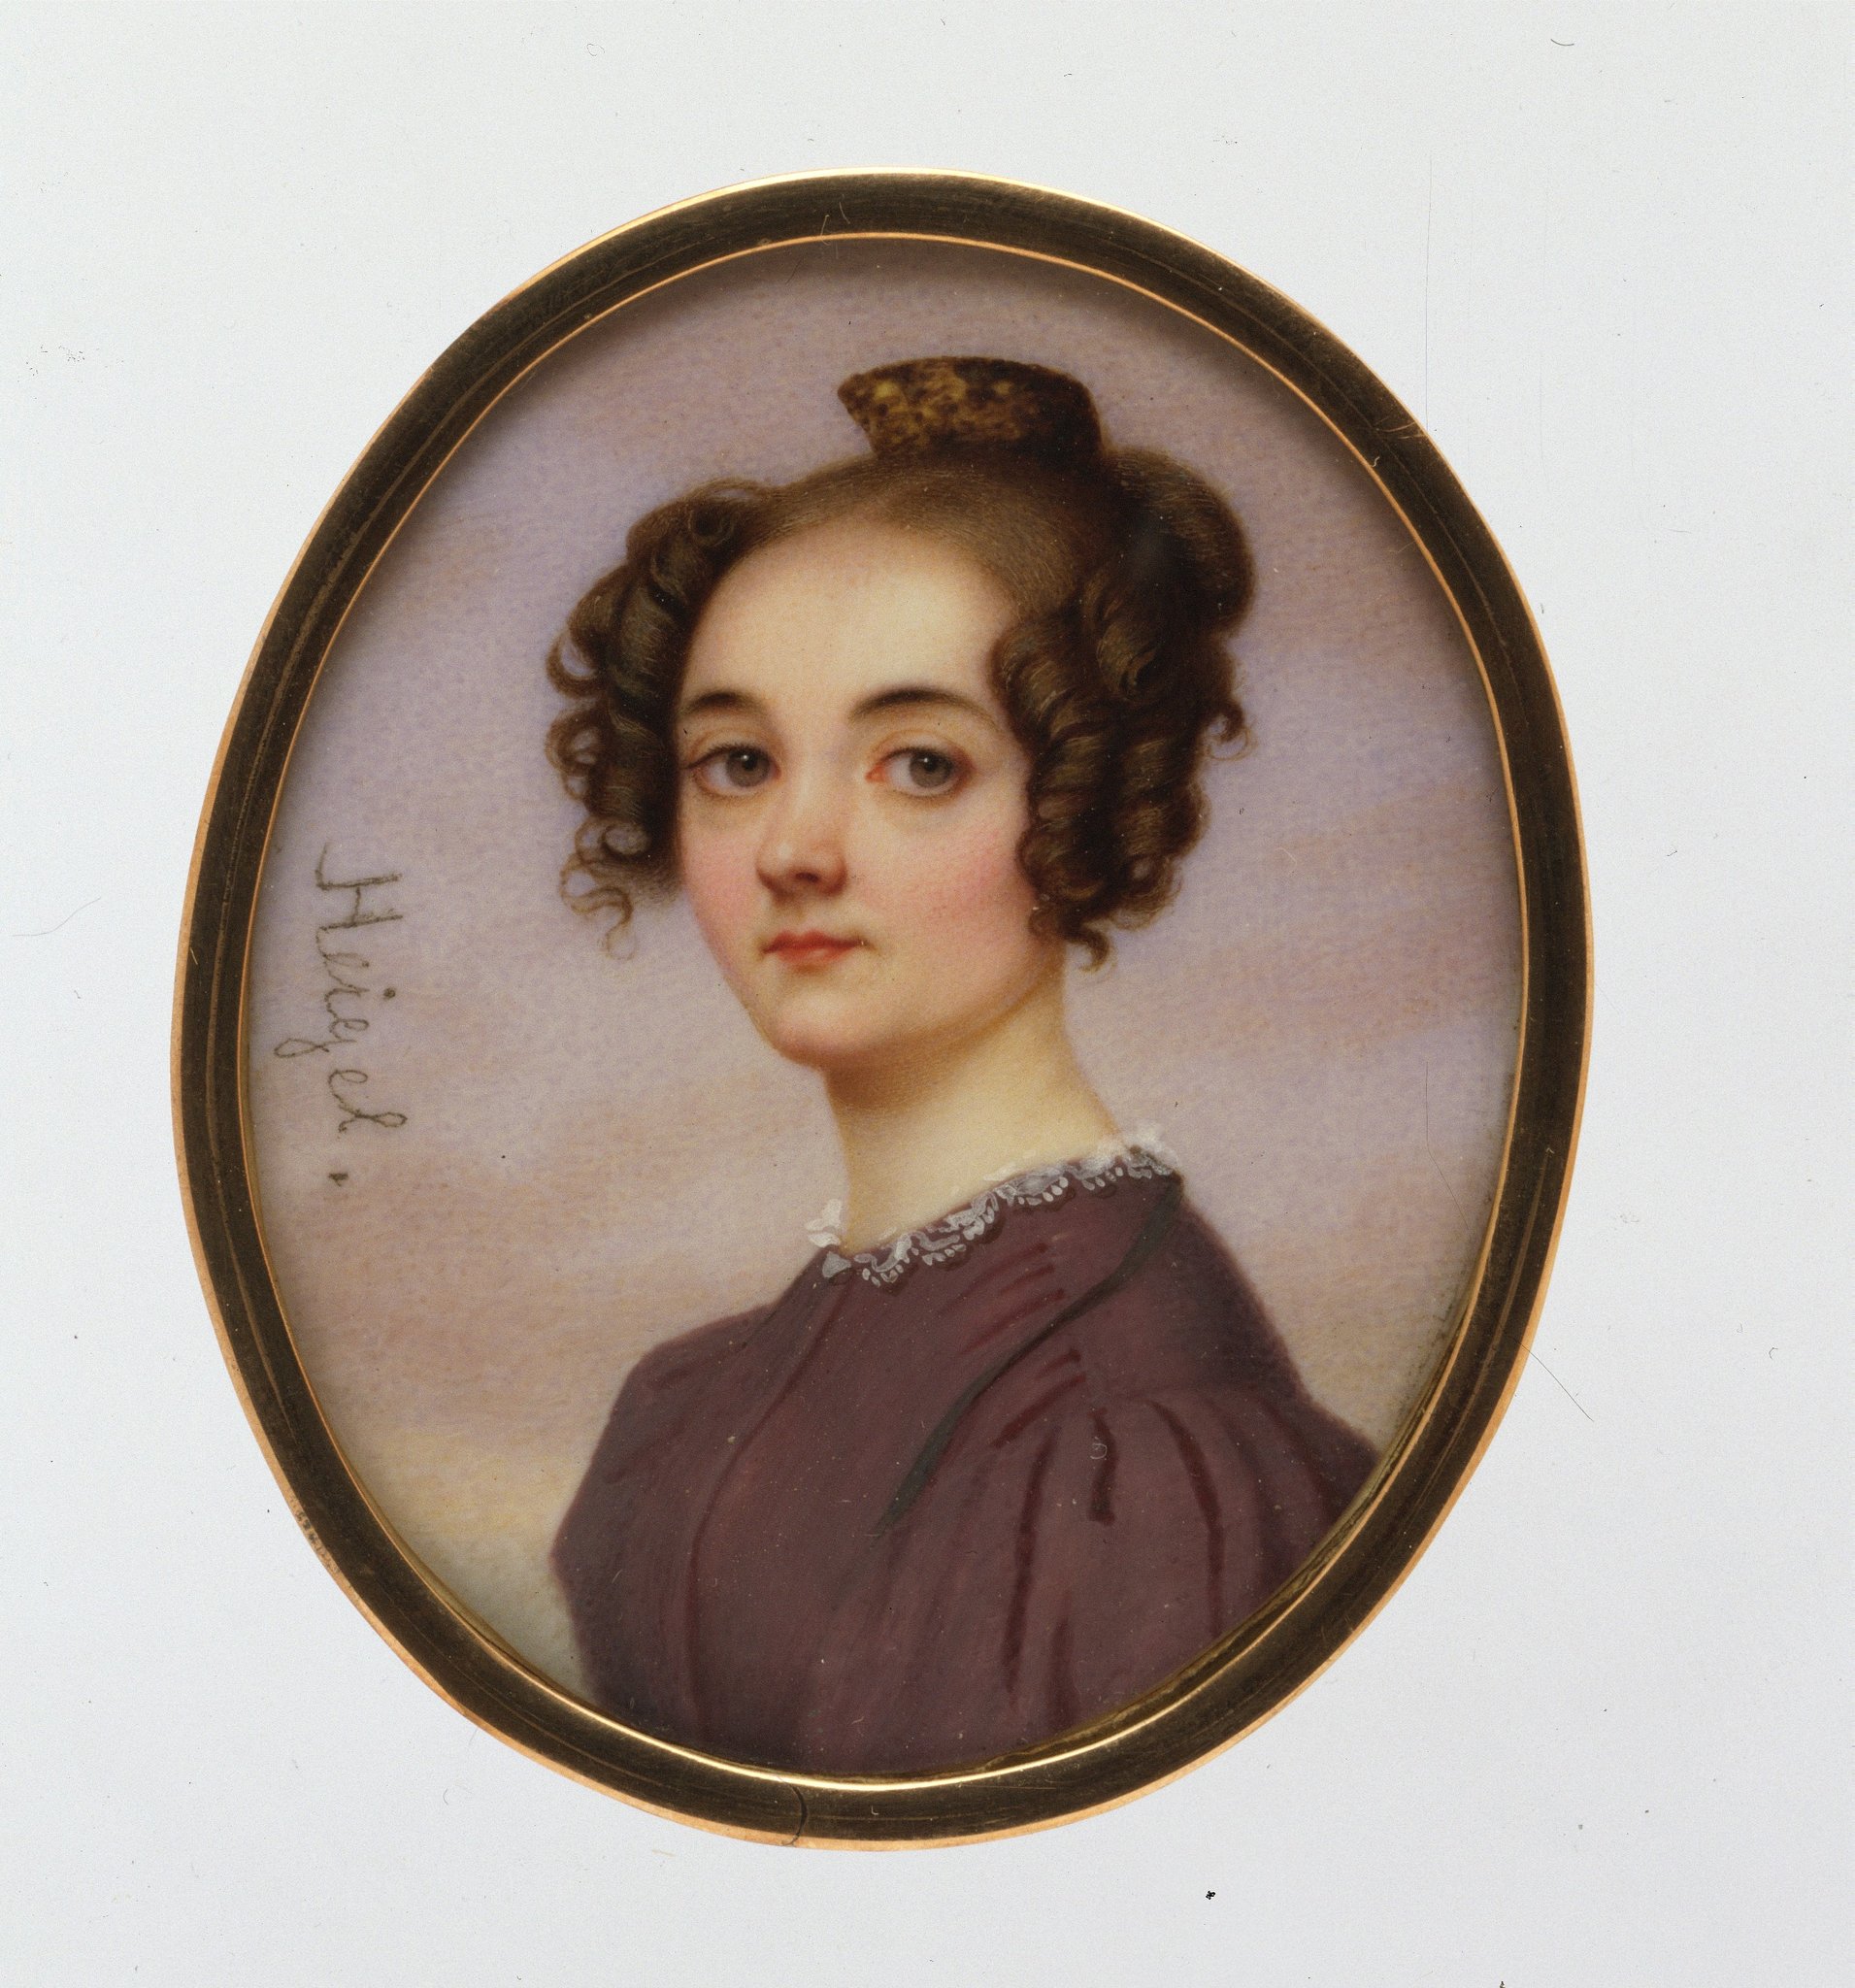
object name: painting, miniature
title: Lola Montez (1818–1861)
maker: josef heigel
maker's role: artist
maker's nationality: german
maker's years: 1780-1837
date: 1800-1837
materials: ivory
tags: portraits,women